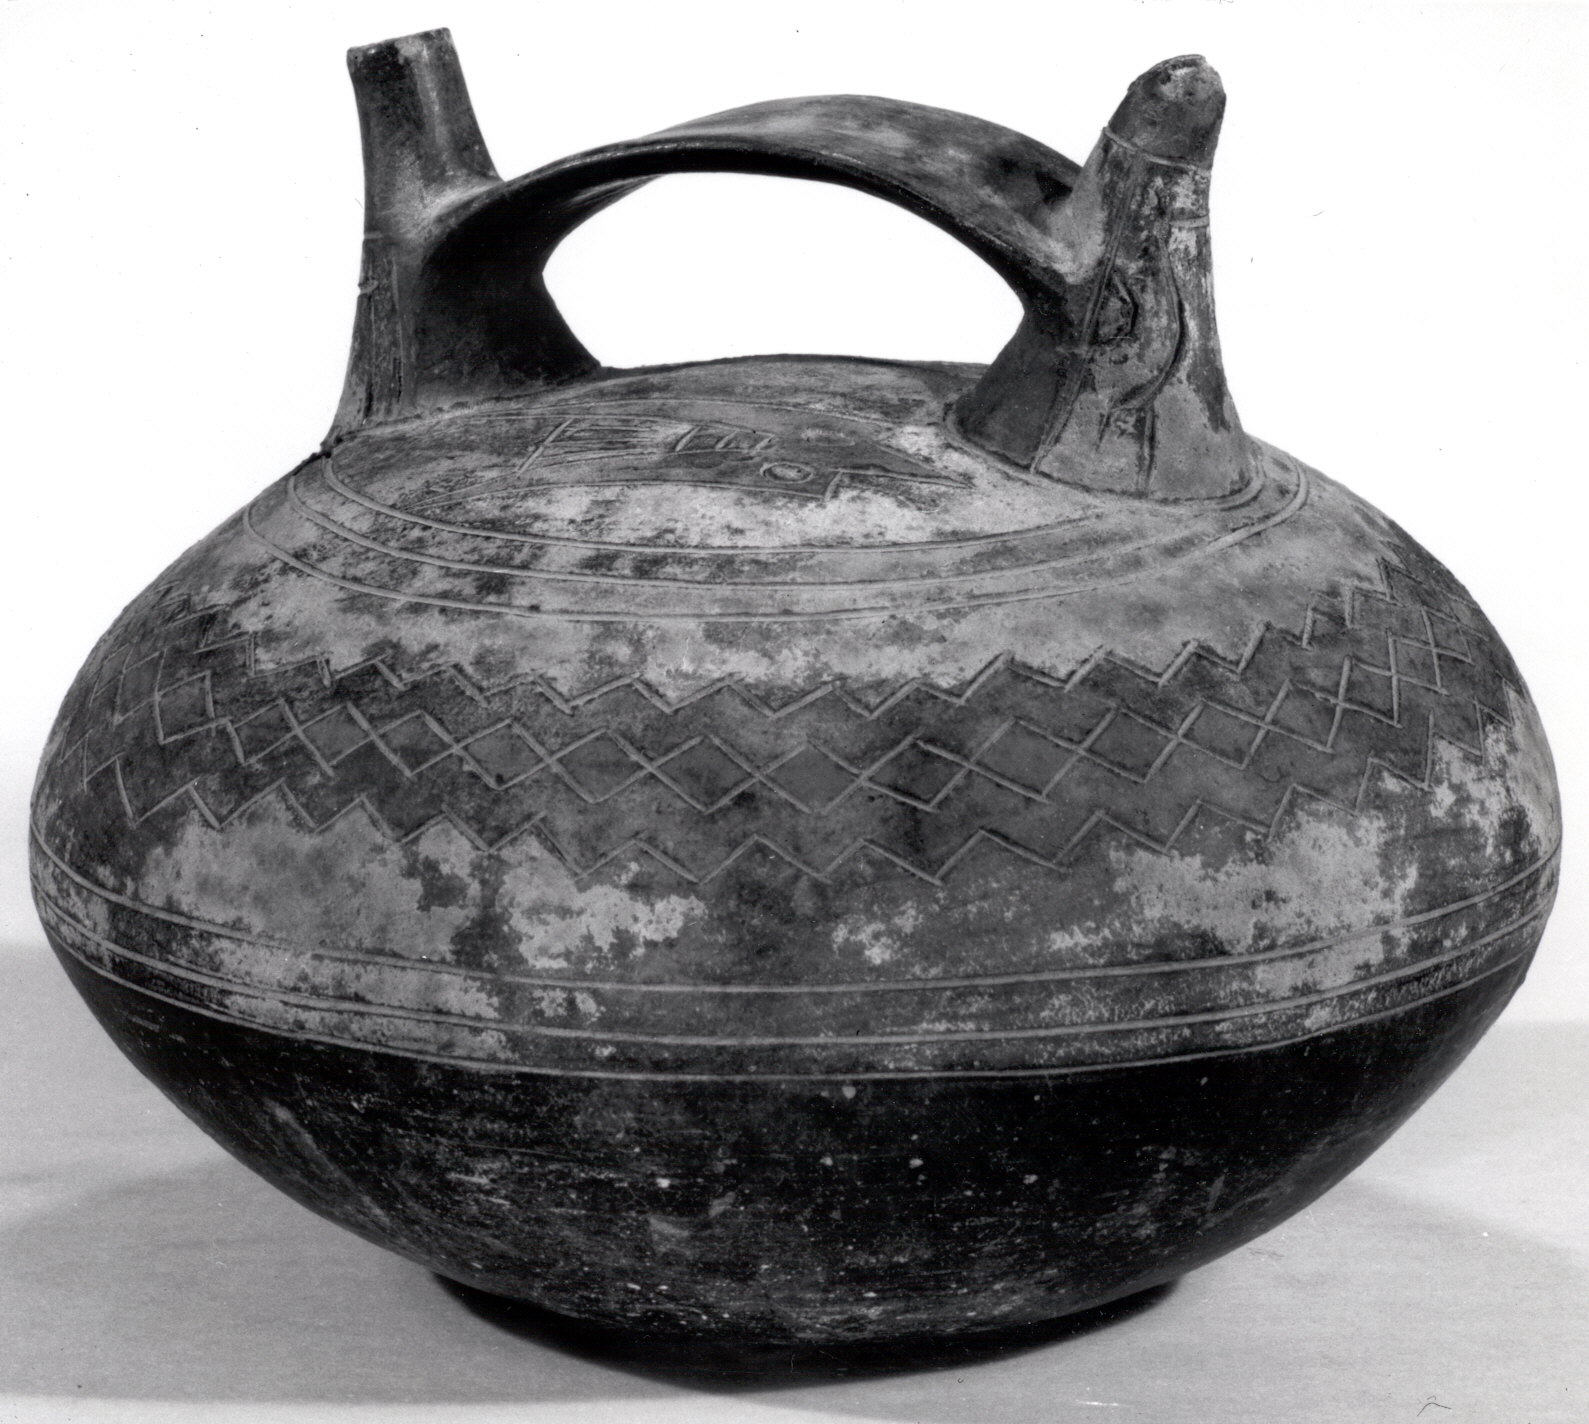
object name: bottle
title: Double Spout and Bridge Bottle with Foxhead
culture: paracas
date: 500-101 BCE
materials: ceramic, pigment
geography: peru